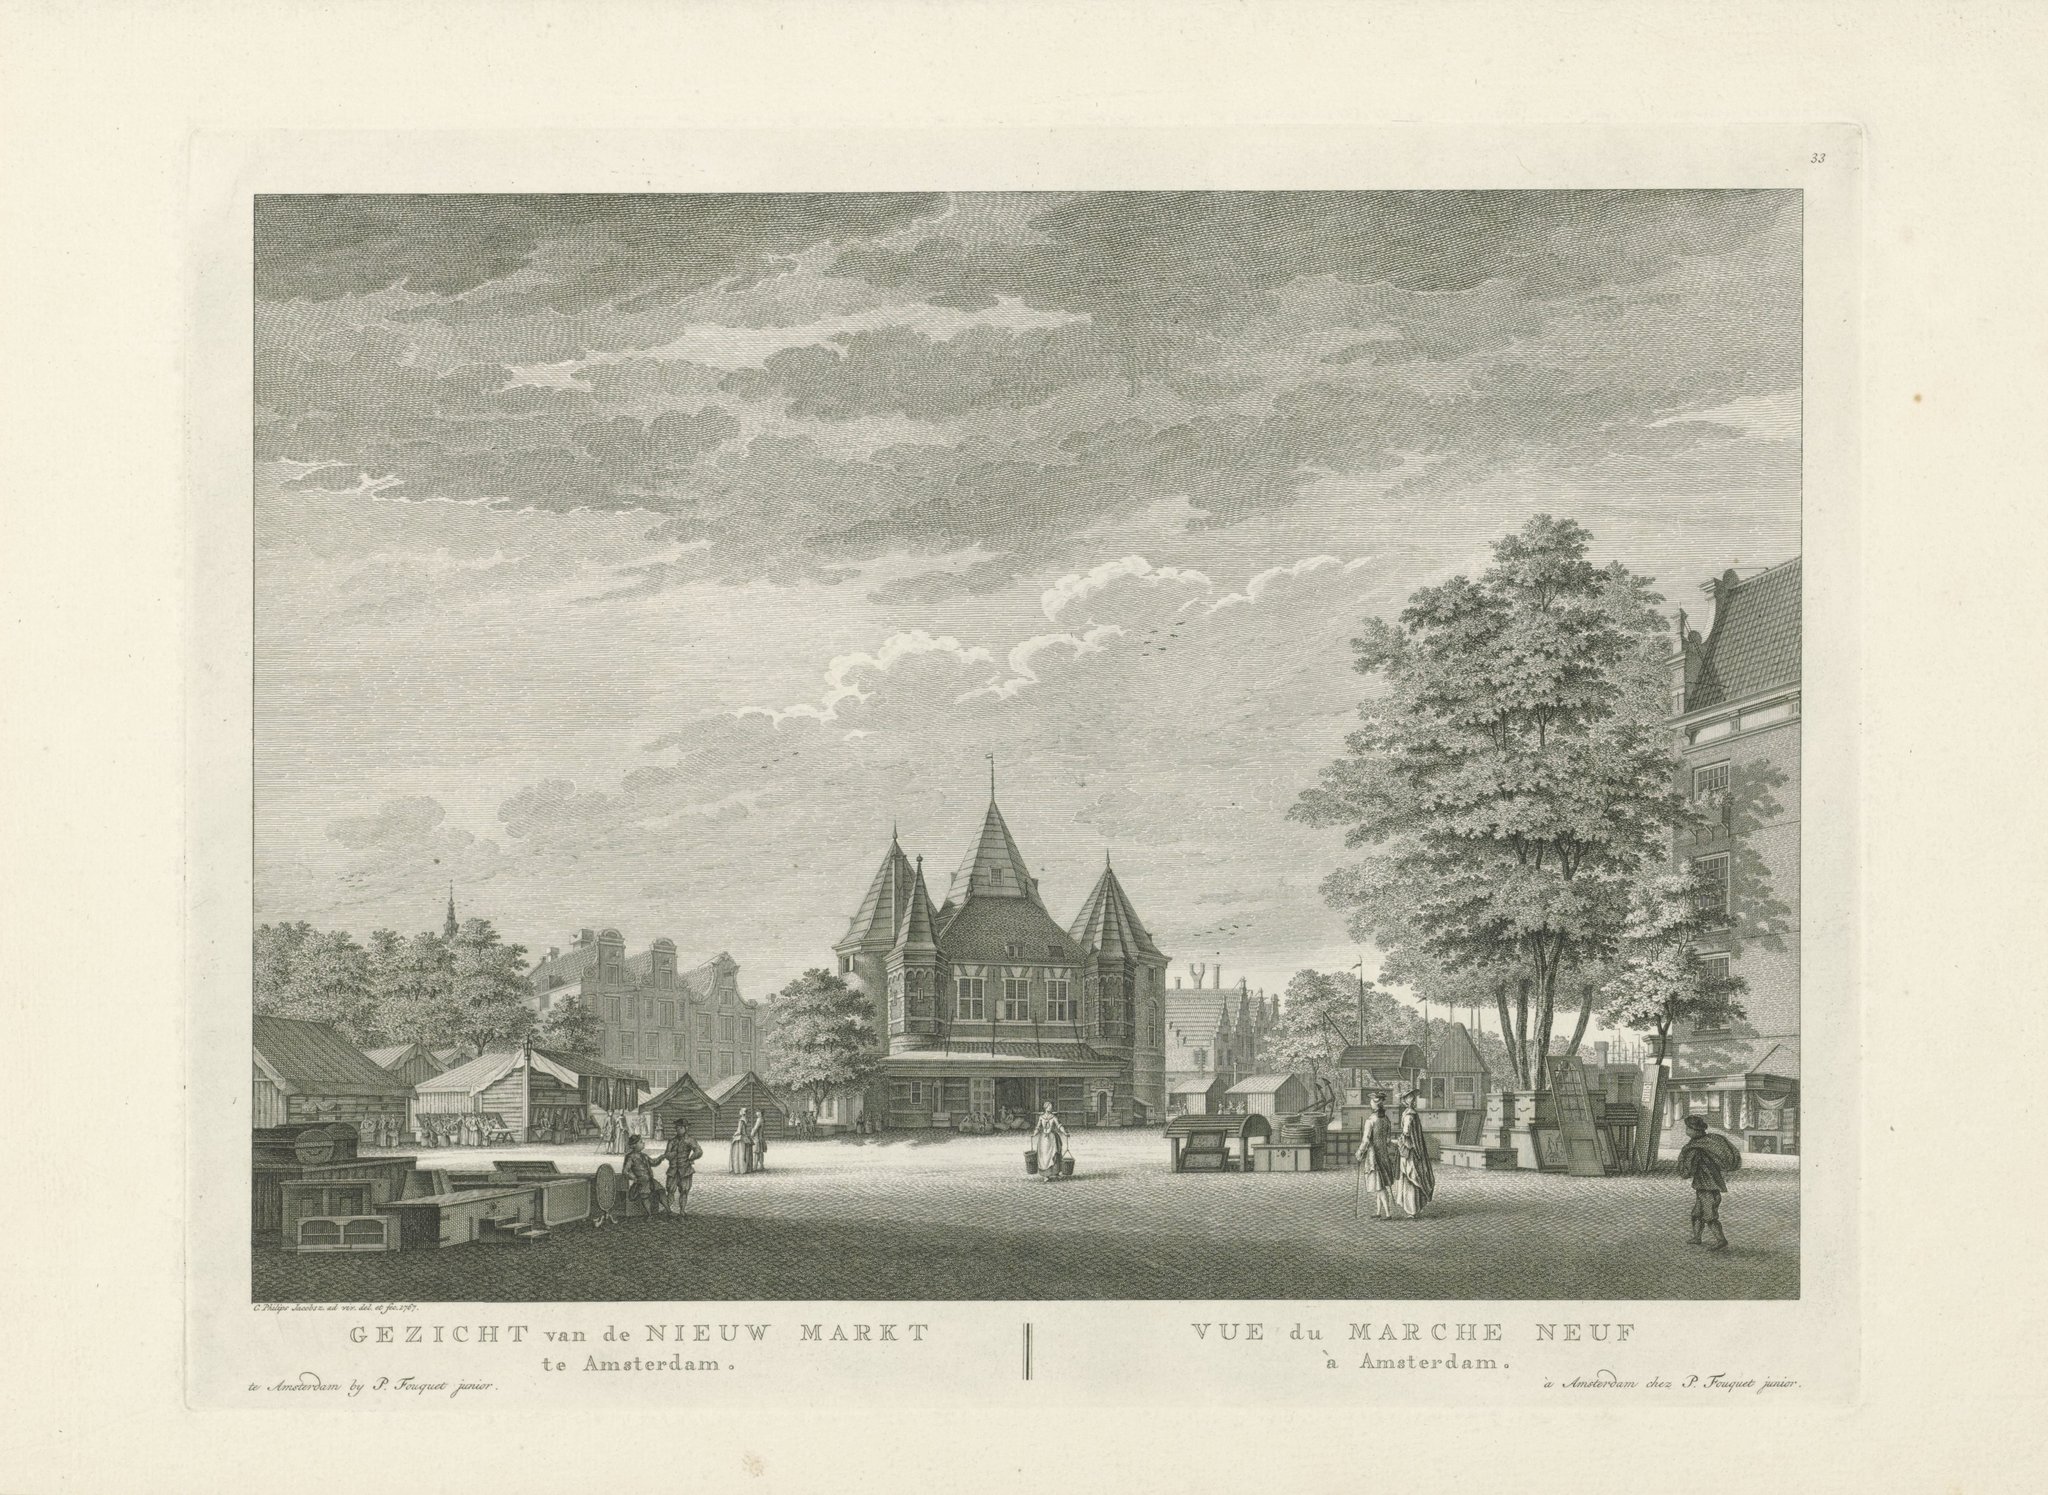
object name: print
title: Gezicht van de Nieuw Markt te Amsterdam / Vue du Marche Neuf à Amsterdam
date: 1767-1783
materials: paper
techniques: engraving, etching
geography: amsterdam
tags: stall, booth (~ market), market, weigh-house, square, place, circus, etc. (+ city(-scape) with figures, staffage)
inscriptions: collector's mark: Lugt 2228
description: Deze prent is ook gebruikt in de zogenaamde Atlas van Fouquet.* Pierre Fouquet gaf vanaf 1760 stadsgezichten van Amsterdam - naar tekeningen van verschillende kunstenaars, gemaakt door verschillende prentmakers - uit. Deze prenten werden aanvankelijk los of in series verkocht. Zoals toen gebruikelijk kon de koper de prenten zelf laten inbinden. Hiertoe gaf Fouquet tussen 1778 en 1783 een titelblad, plattegrond en inhoudsopgave van de tot dusver 100 uitgegeven prenten uit (1). Gezien de inhoud afhankelijk was van wat de koper had verzameld verschilt de inhoud van de verschillende bewaarde Fouquetatlassen onder deze titel sterk. Ook zijn er exemplaren bekend waar tevens andere prenten aan zijn toegevoegd. Omdat er behoefte bleek aan uitleg bij de platen werd in 1783 een nieuwe versie van de atlas uitgegeven, aangevuld met tekst en twee prenten. De aangegeven volgorde veranderde maar de platen van de al eerder uitgegeven prenten bleven ongewijzigd. Deze uitgave werd in opdracht van Fouquet gedrukt bij Daniël Jean Changuion en Petrus den Hengst (2). Een tiental platen werd bijgewerkt en verscheen, met nieuw impressum, in het vervolg van Wagenaars geschiedenis van Amsterdam, uitgeven door Petrus Conradi en Folkert van der Plaats (3). Een aantal jaar na het overlijden van Fouquet kwam Evert Maaskamp met een nieuwe uitgave van de atlas, met verbeterde tekst en toevoeging van twee prenten. Op alle platen verwijderde hij het oude en liet hij zijn eigen impressum zetten (4). De huidige staat van de prent komt voor in exemplaren van de onder (1) en (2) genoemde werken. * Onder de Atlas van Fouquet of Fouquetatlas verstaan we de hieronder vermelde publicaties (1), (2) en (4). (1). Afbeeldingen van de wyd-vermaarde koopstad Amsterdam benevens des zelvs voornaamste gebouwen en gezigten alle naar het leeven getekend / Receuil des edifices les plus considerables et des plus belles vues, de la fameuse ville d'Amsterdam, dessinées d'après nature. Amsterdam: Pierre Fouquet, 1778-1783. (2). Nieuwe atlas, van de voornaamste gebouwen en gezigten der stad Amsterdam, met derzelver beknopte beschryvingen. 2 delen. Amsterdam: Daniël Jean Changuion en Petrus den Hengst [in opdracht van Pierre Fouquet], 1783. (3). Stijl, Simon. Amsterdam, in zyne geschiedenissen, voorregten, koophandel, gebouwen, kerkenstaat, schoolen, schutterye, gilden en regeeringe, beschreeven. Om te dienen ten vervolge op het werk van Jan Wagenaar (…). 10 delen. Amsterdam en Harlingen: Petrus Conradi en Folkert van der Plaats, 1788-1801. (4). Nieuwe atlas, van de voornaamste gebouwen en gezigten der stad Amsterdam. Met derzelver beknopte beschryvingen. Amsterdam: Evert Maaskamp, 1805. * Het aantal vermelde staten is gebaseerd op het aantal gevonden staten. Mogelijk zijn er meer staten van deze prent. Voor vierde bekende staat zie RP-P-1905-571.